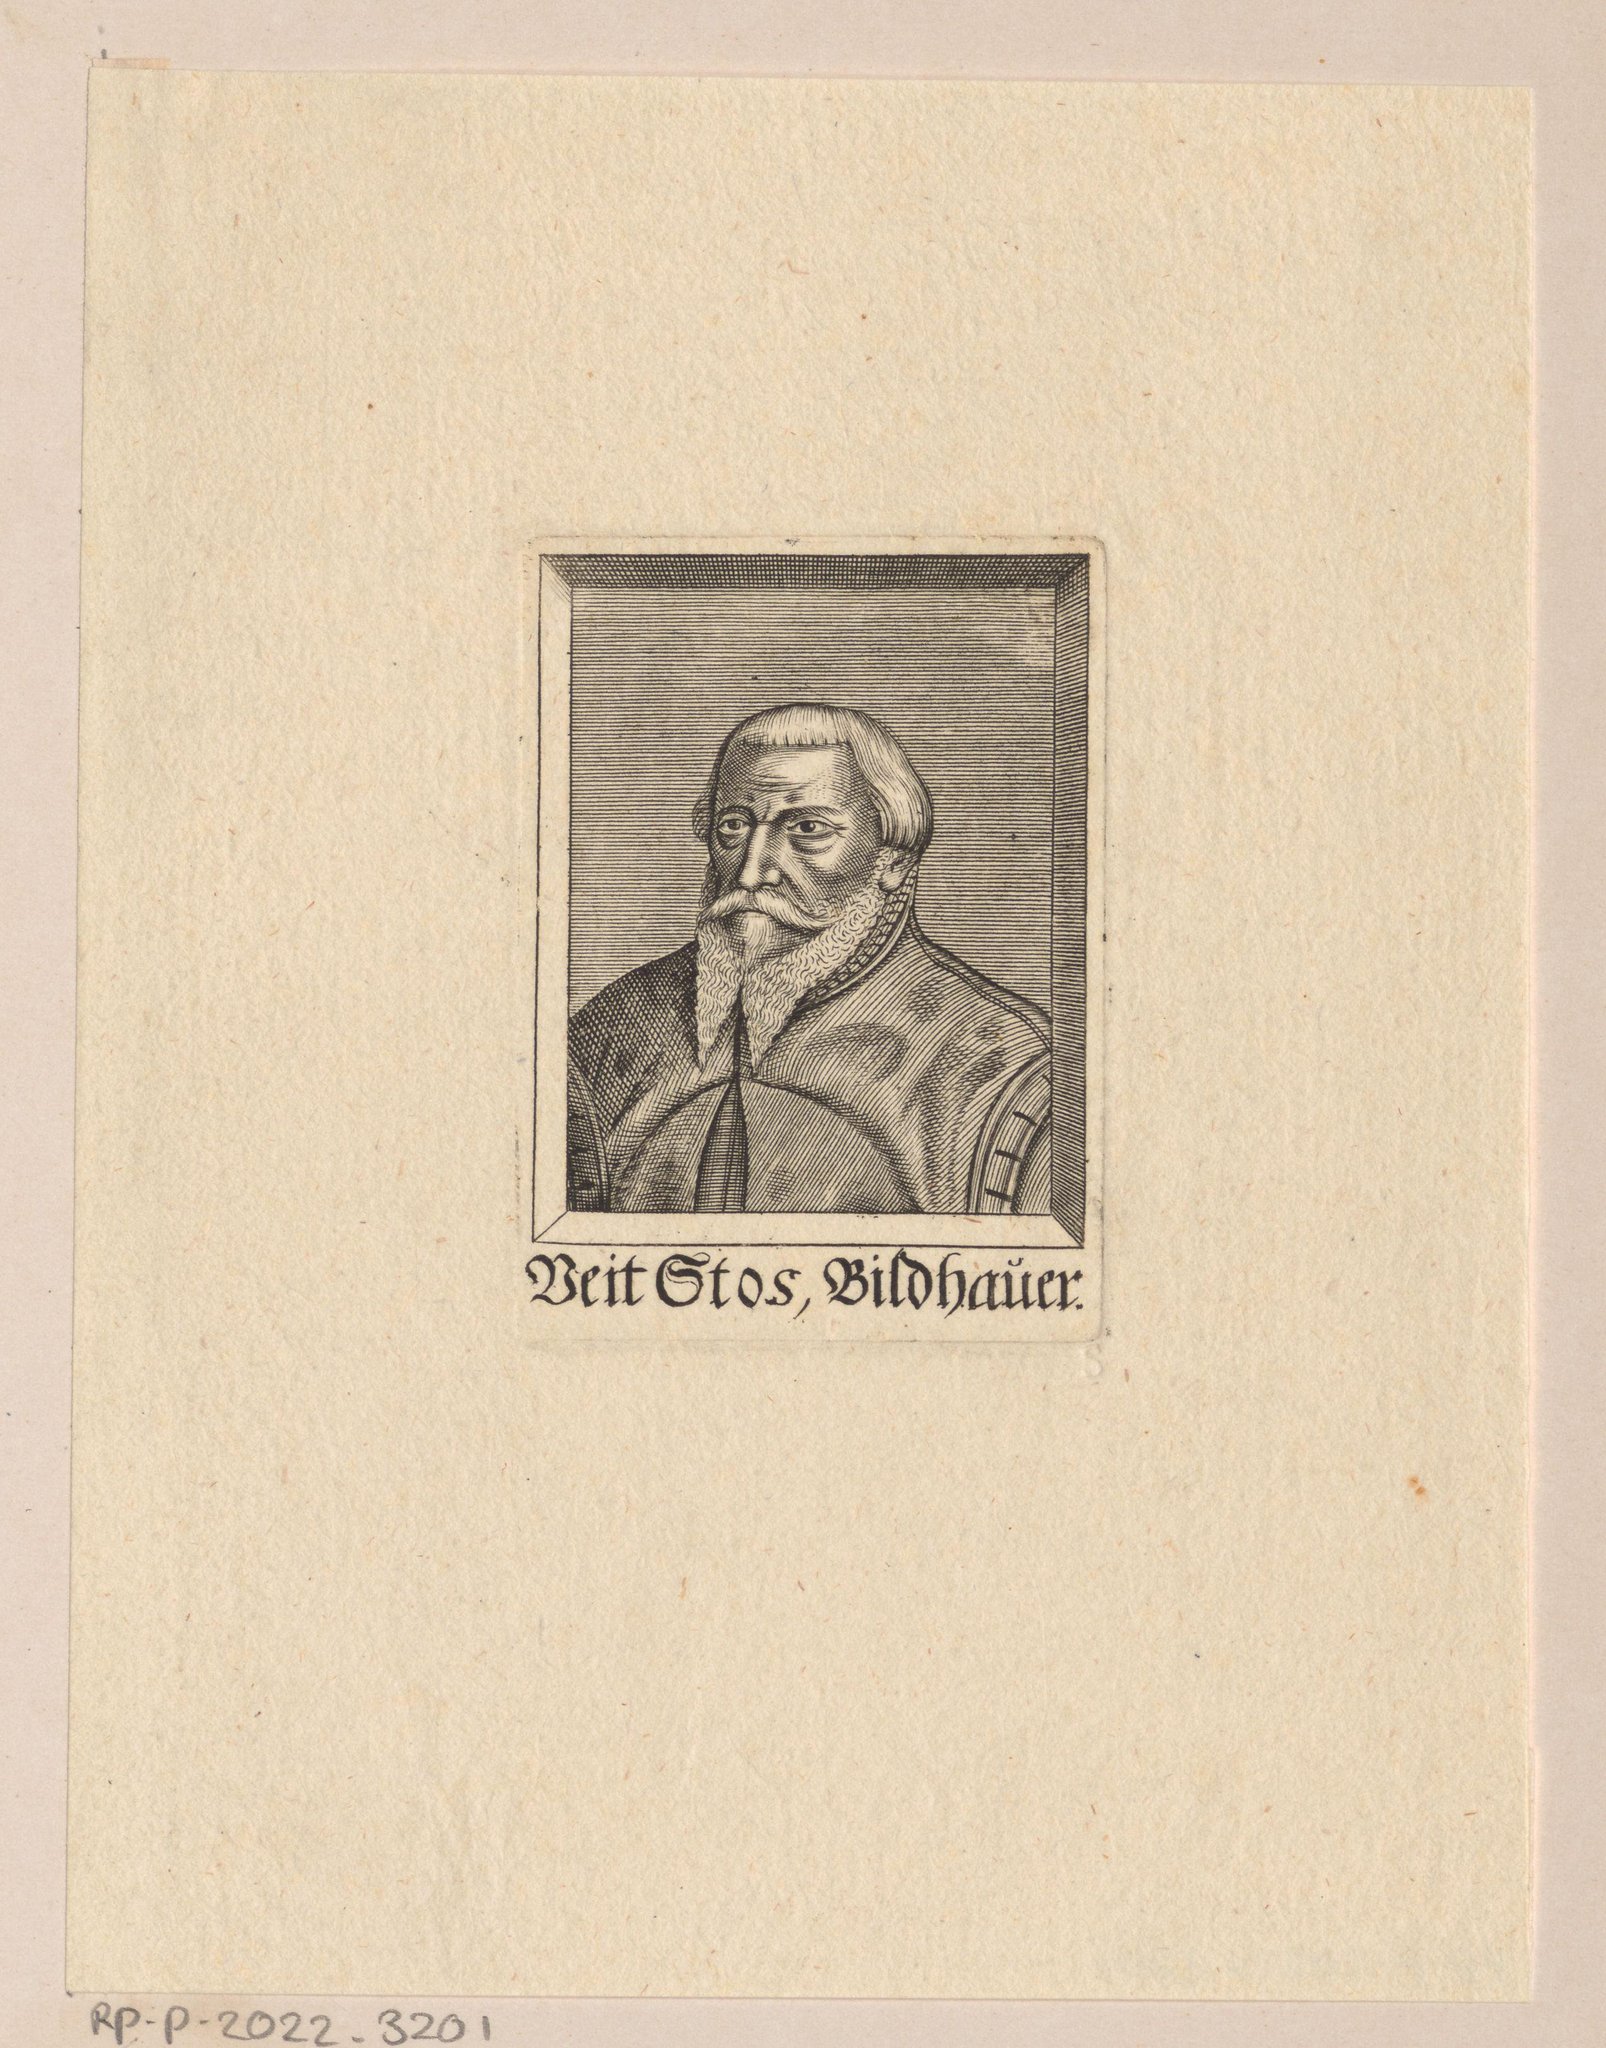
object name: print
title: Portret van Veit Stoss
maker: Anonymous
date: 1600-1699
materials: paper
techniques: engraving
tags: sculptor, portrait, self-portrait of sculptor, historical persons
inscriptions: check stamp: ‘S’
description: Met eenregelig onderschrift in het Duits.